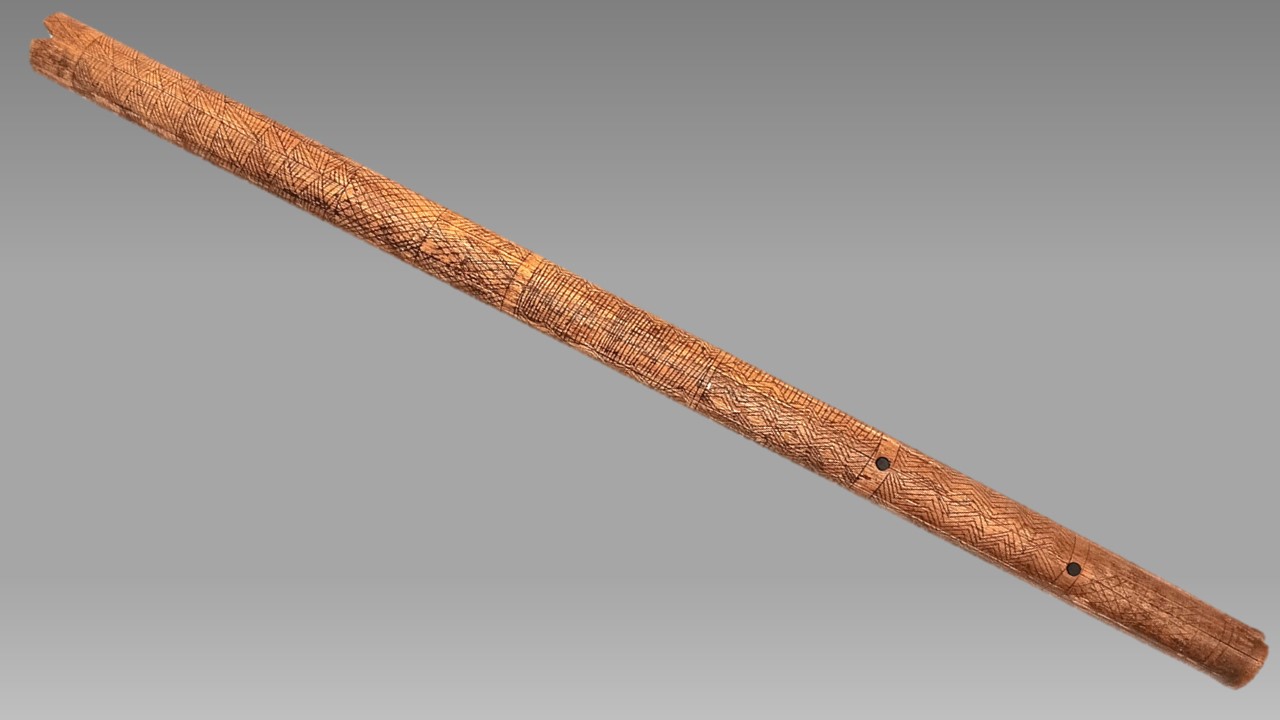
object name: khore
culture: melanesian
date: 1867-1900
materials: bamboo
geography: vanuatu